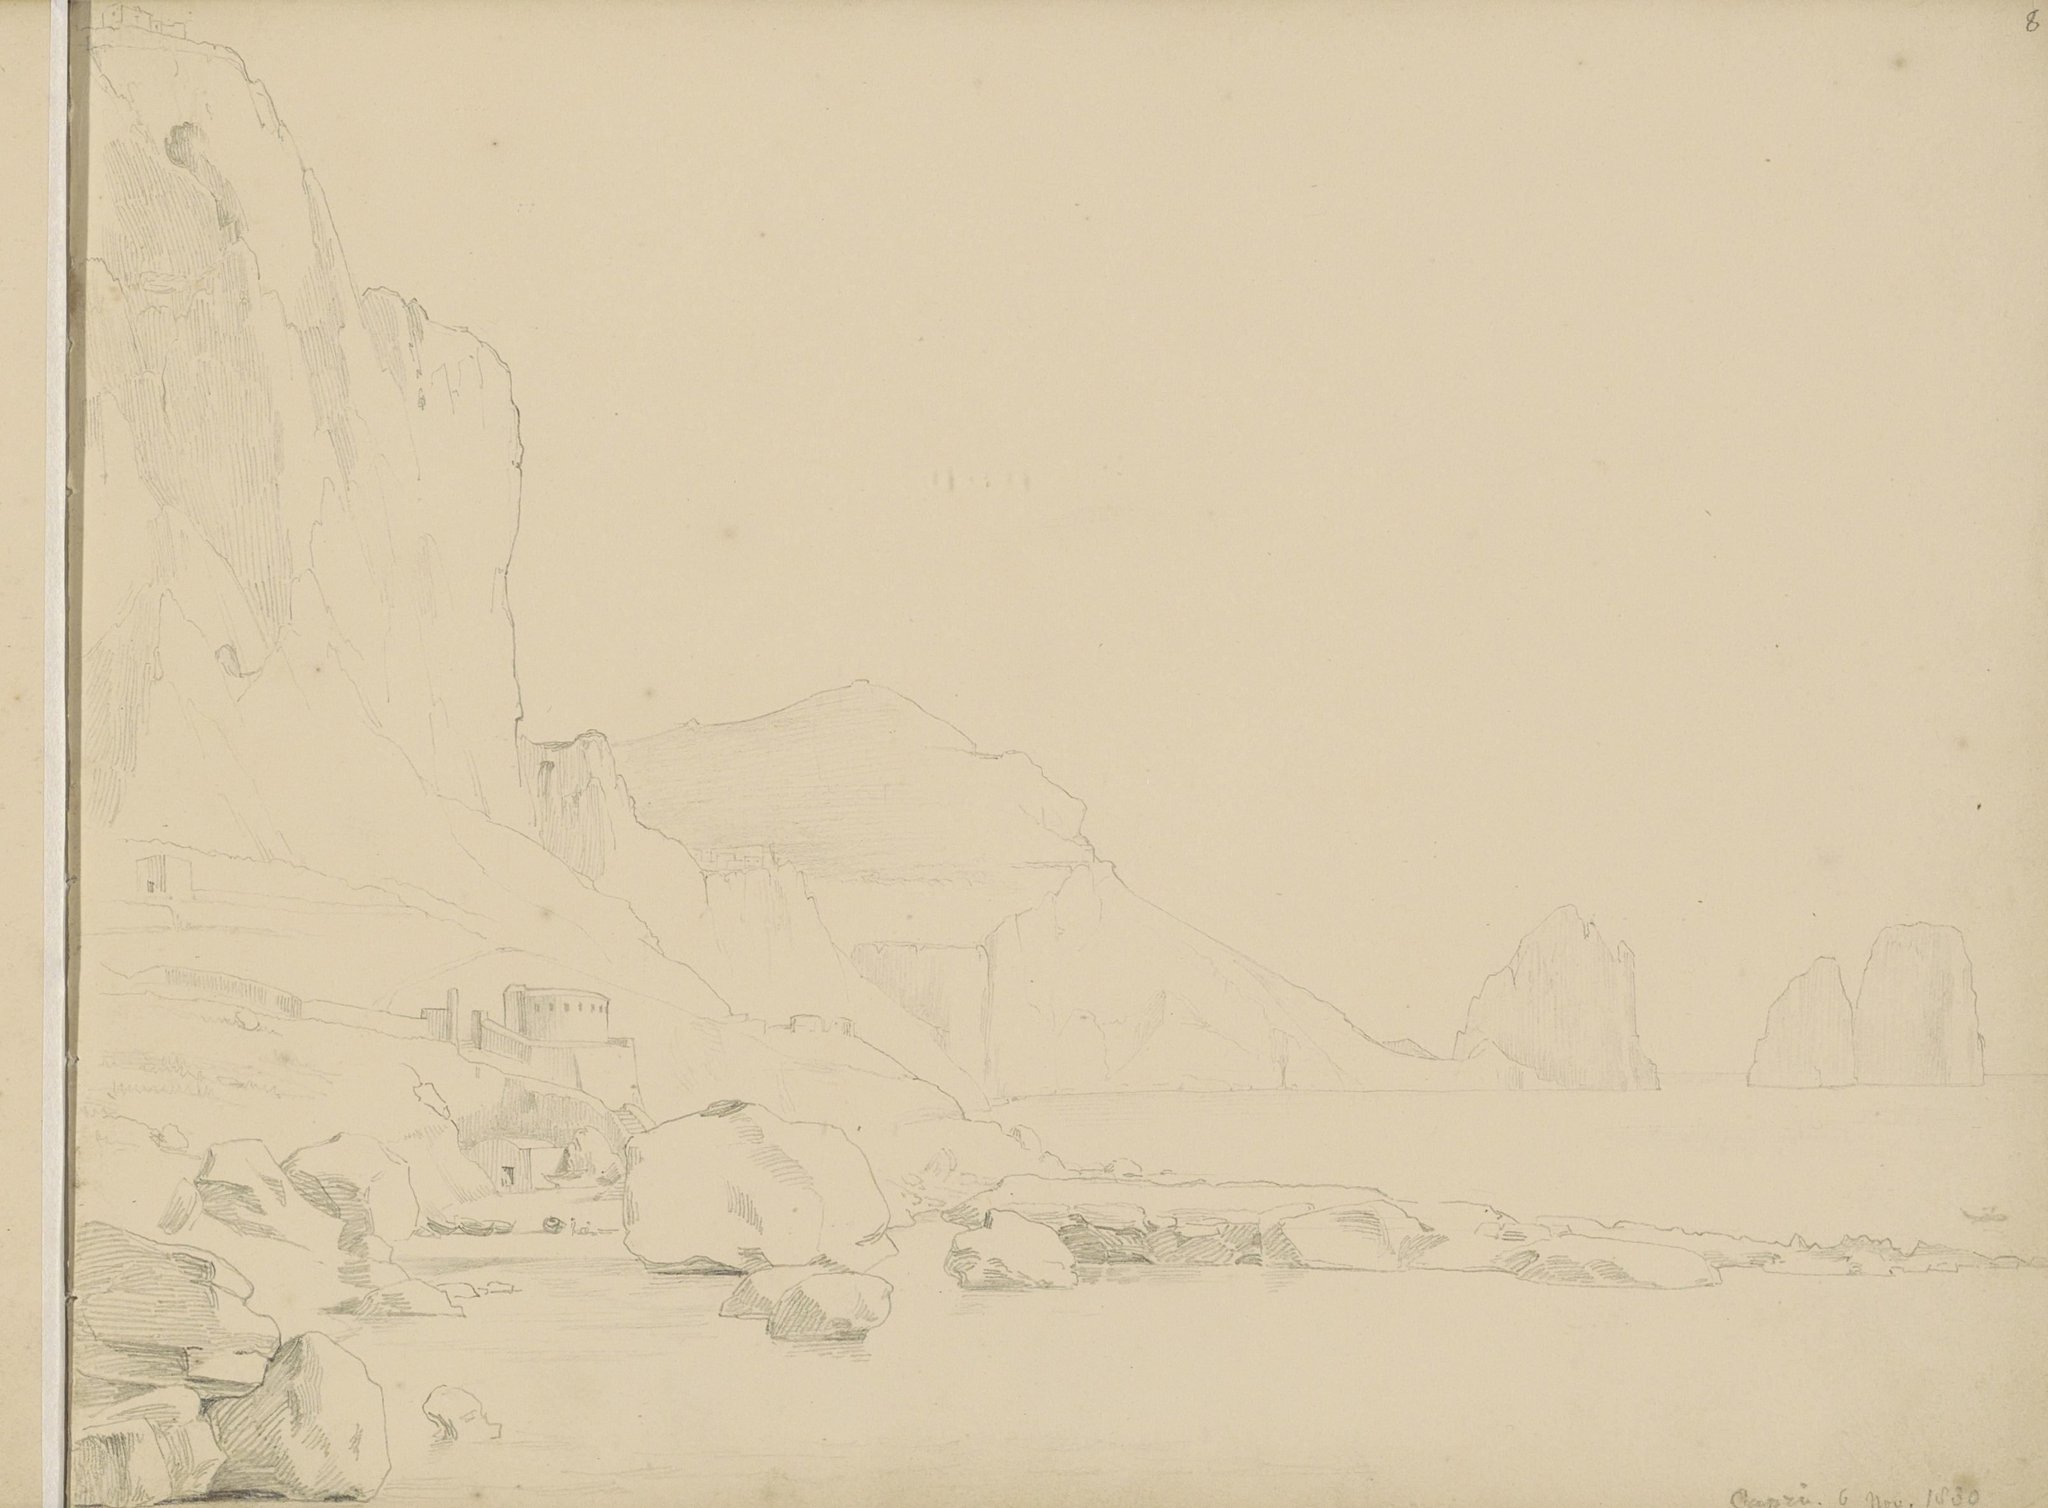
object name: sketchbook leaf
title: Kust van Capri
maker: jacobus everhardus josephus van den berg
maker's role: draughtsman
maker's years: 1802-1861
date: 1811-1830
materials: paper, pencil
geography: capri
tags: rocky coast, capri, isola di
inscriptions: date and inscription: ‘Capri. 6 nov. 1830’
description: Blad 8 recto uit een schetsboek met 26 bladen.